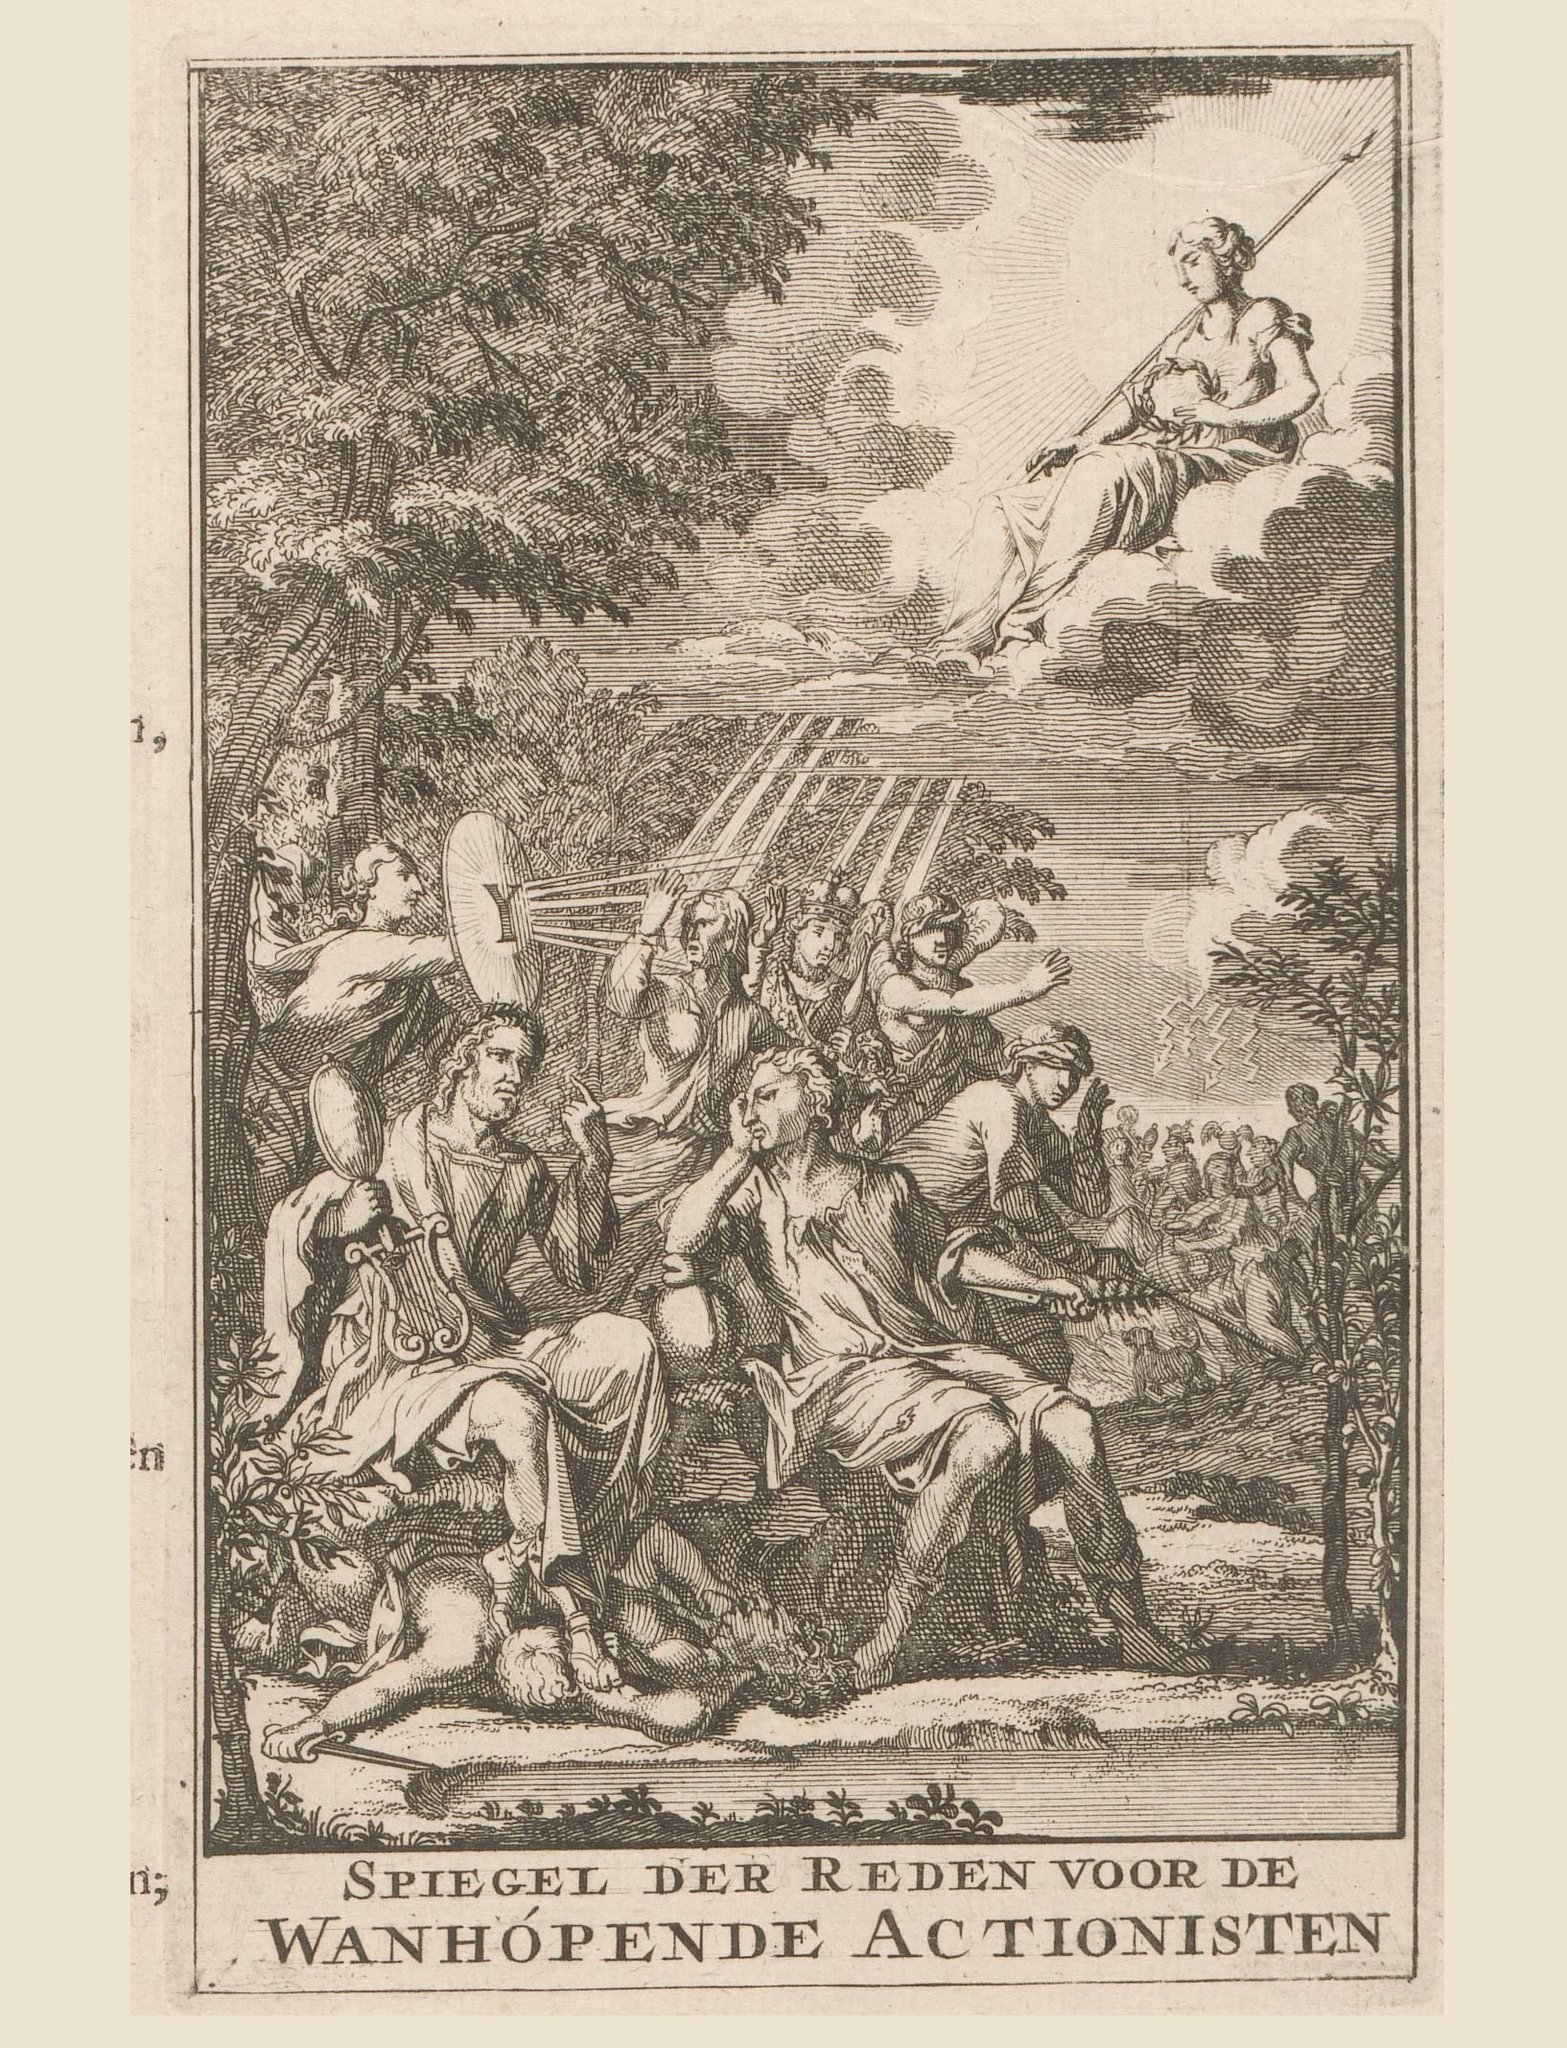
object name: print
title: Het Groote Tafereel der Dwaasheid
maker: jacobus schijnvoet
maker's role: draughtsman, print maker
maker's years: 1685-1743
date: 1720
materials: paper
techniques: engraving, etching, letterpress printing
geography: amsterdam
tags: financial panic, rationality, reasoning; 'ratiocinatione o discorso' (ripa) (+ abstract concept represented by male figure)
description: Spiegel der Reden voor de wanhopende Actionist. Een windhandelaar die op het punt staat zich met een dolk in de borst te steken wordt door de personificatie van de Reden een spiegel voorgehouden. Op de achtergrond houdt de Voorzichtigheid met een schild gemerkt Y (= het IJ te Amsterdam) de windhandel tegen. Op het blad om de plaat staan drie delen tekst. Prent in de gebonden eerste uitgave (304 B 10) van Het Groote Tafereel der Dwaasheid met spotprenten op de Windhandel of Actiehandel van 1720.